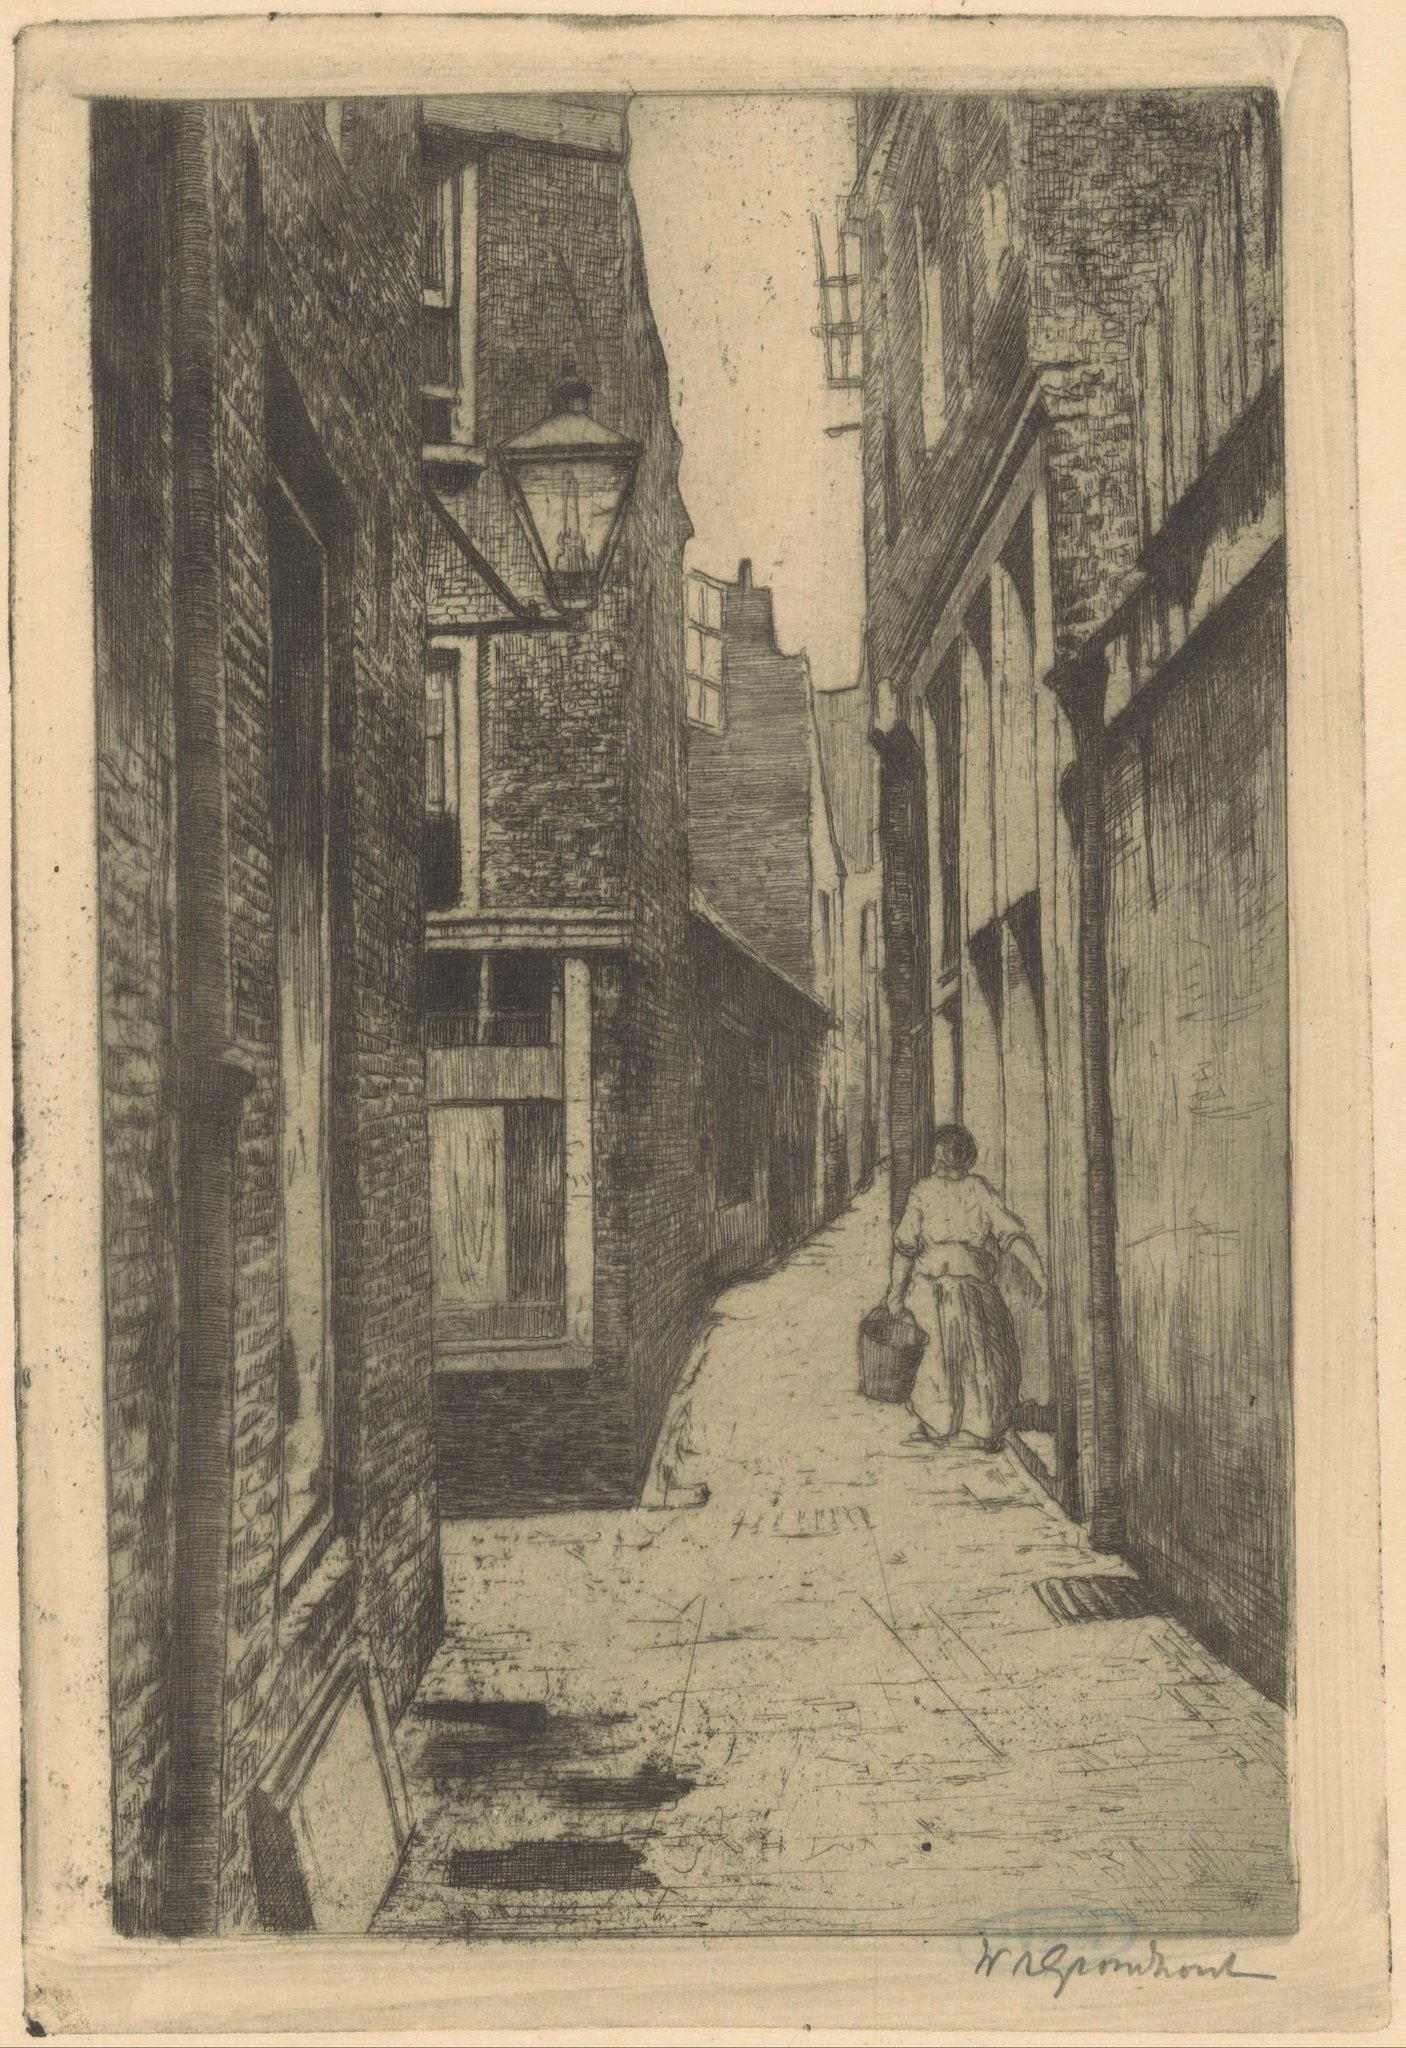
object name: print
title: Straat in Rijswijk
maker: willem adrianus grondhout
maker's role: draughtsman, painter, print maker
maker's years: 1878-1934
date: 1888-1934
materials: paper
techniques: etching, intaglio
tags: street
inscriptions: collector's mark: Lugt 2228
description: Er loopt een vrouw met een emmer in de straat.